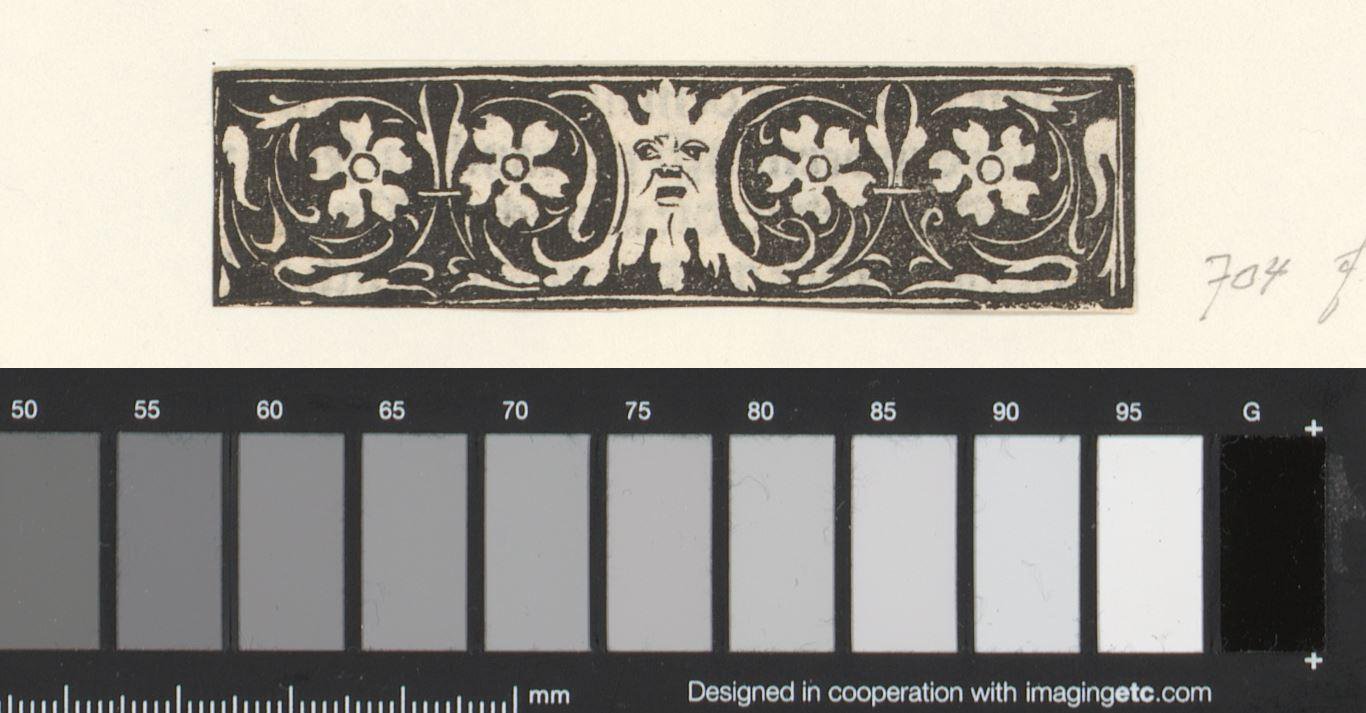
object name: book illustration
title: Masker en ornamenten met bladmotief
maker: Anonymous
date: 1514-1532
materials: paper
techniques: letterpress printing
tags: foliage ~ ornament, mask, mascaron ~ ornament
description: Deze prent is gebruikt als ornament in: Petrarca, Francesco. Von der Artzney bayder Glück, des guten und widerwertigen: unnd weß sich ain yeder inn Gelück und Unglück halten sol (...). Augsburg: Heinrich Steiner, 1532. Deze uitgave is ook bekend onder de titel 'Trostspiegel in Glück und Unglück'.